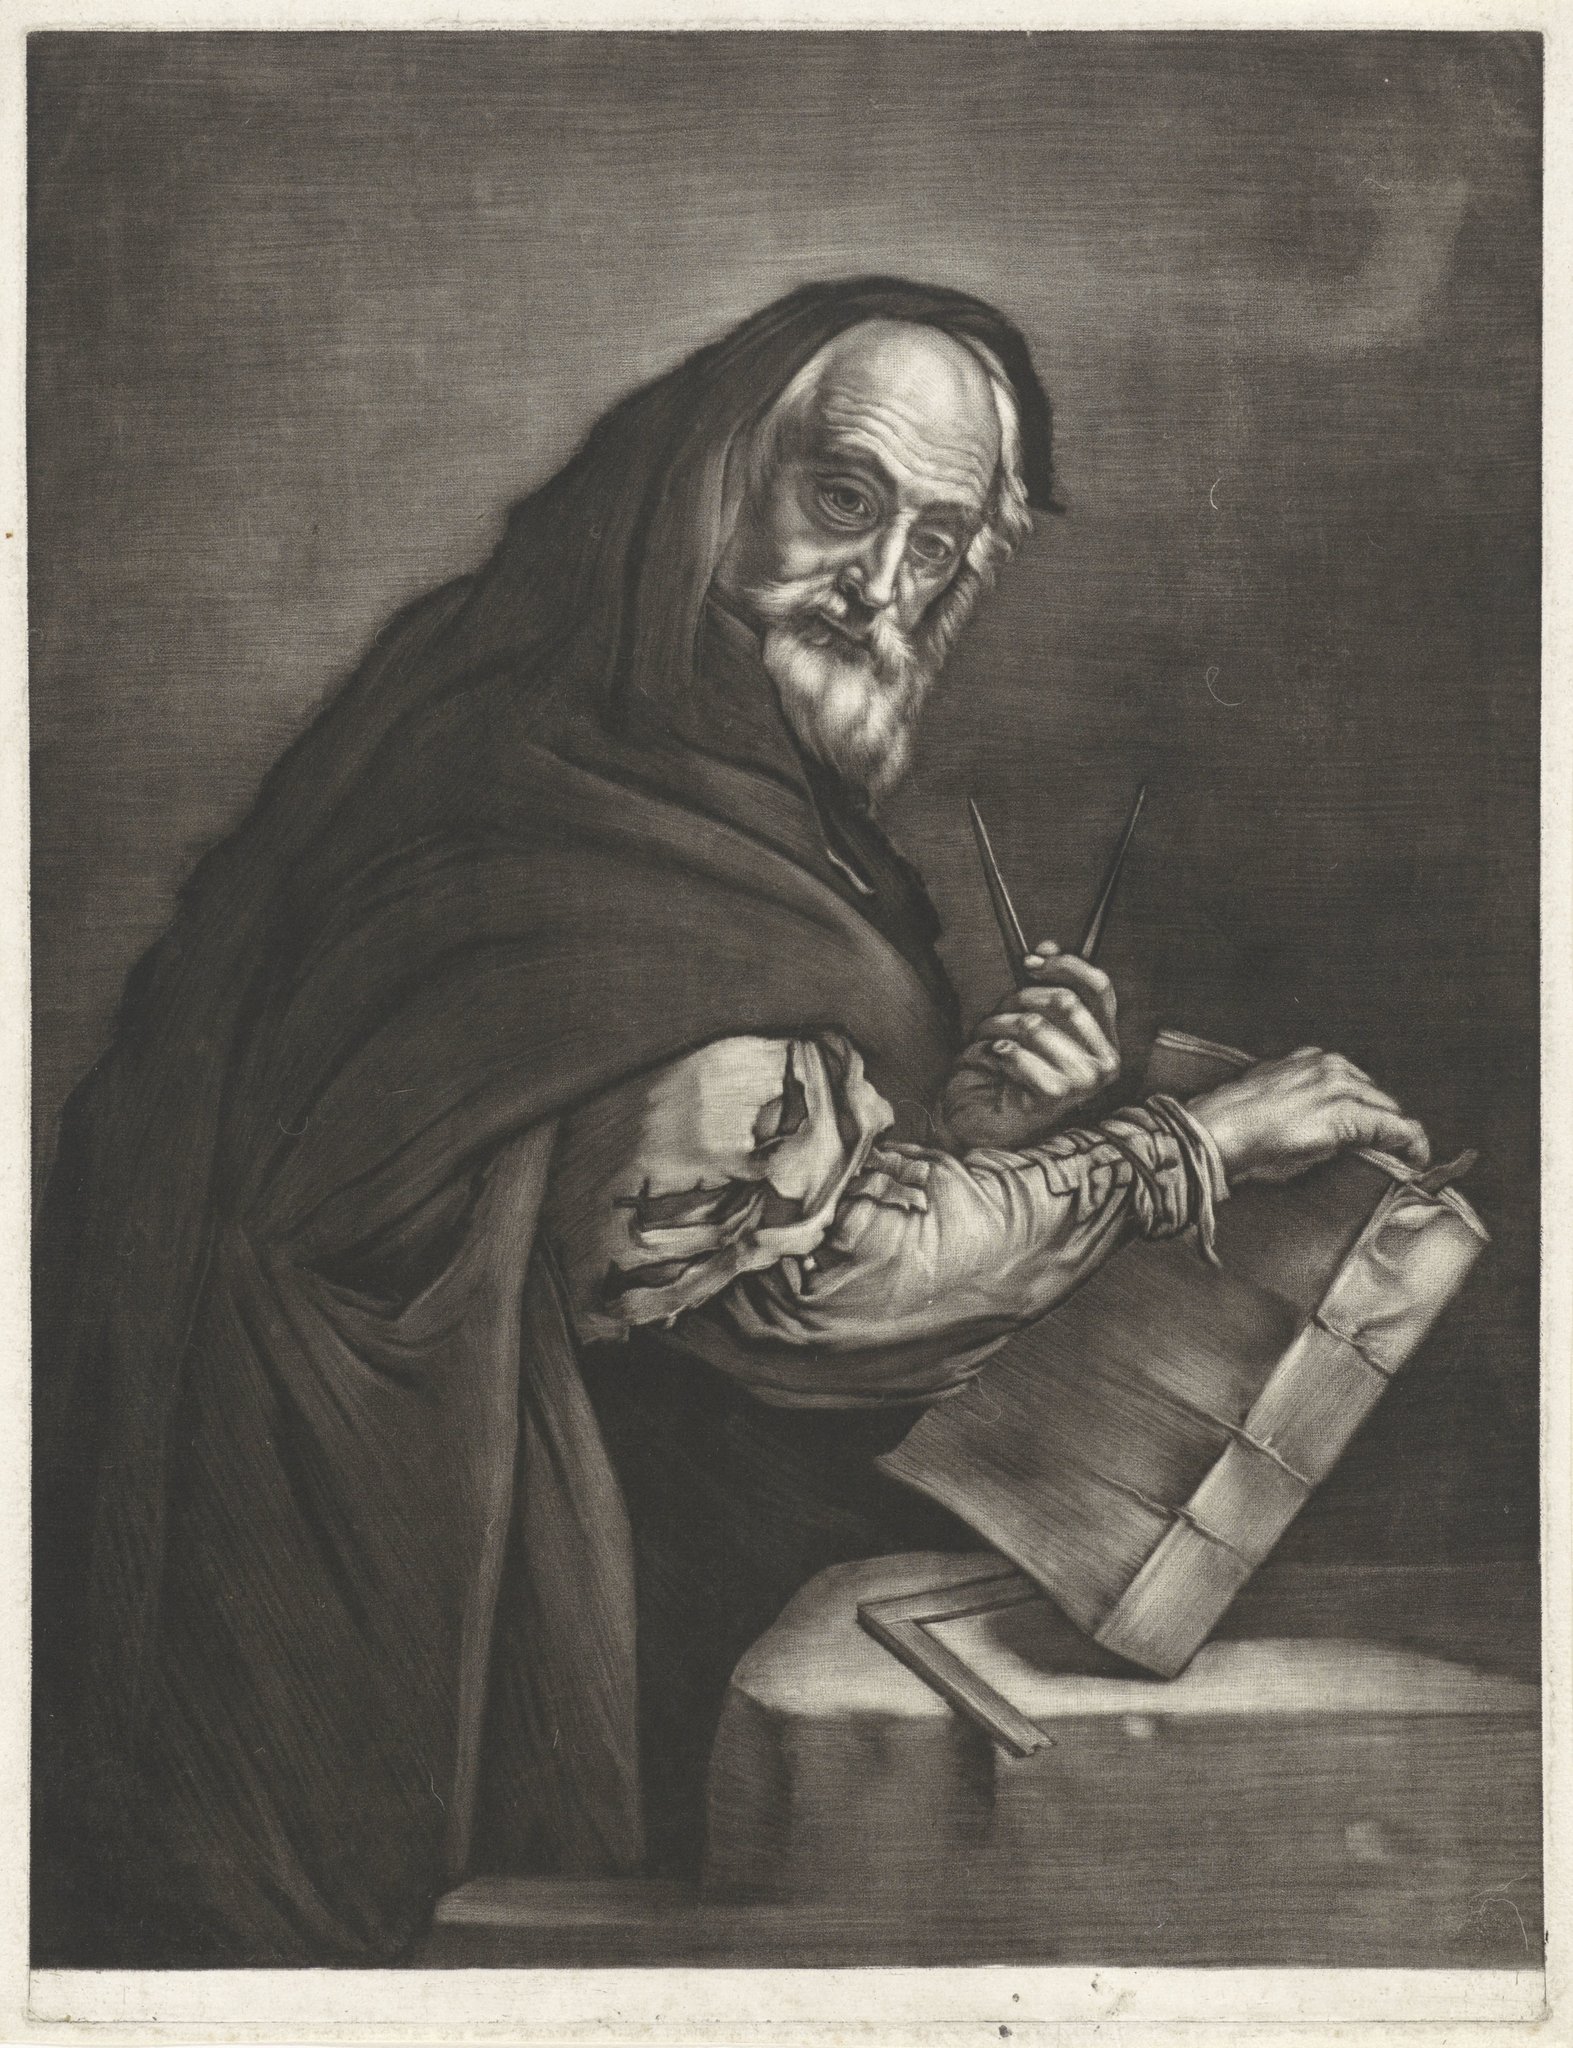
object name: print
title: Filosofen naar Spaanse voorbeelden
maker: bernard vaillant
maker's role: draughtsman, painter, print maker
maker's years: 1632-1698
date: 1672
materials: paper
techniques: mezzotint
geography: amsterdam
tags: scholar, philosopher, compasses, book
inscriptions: collector's mark: Lugt 240